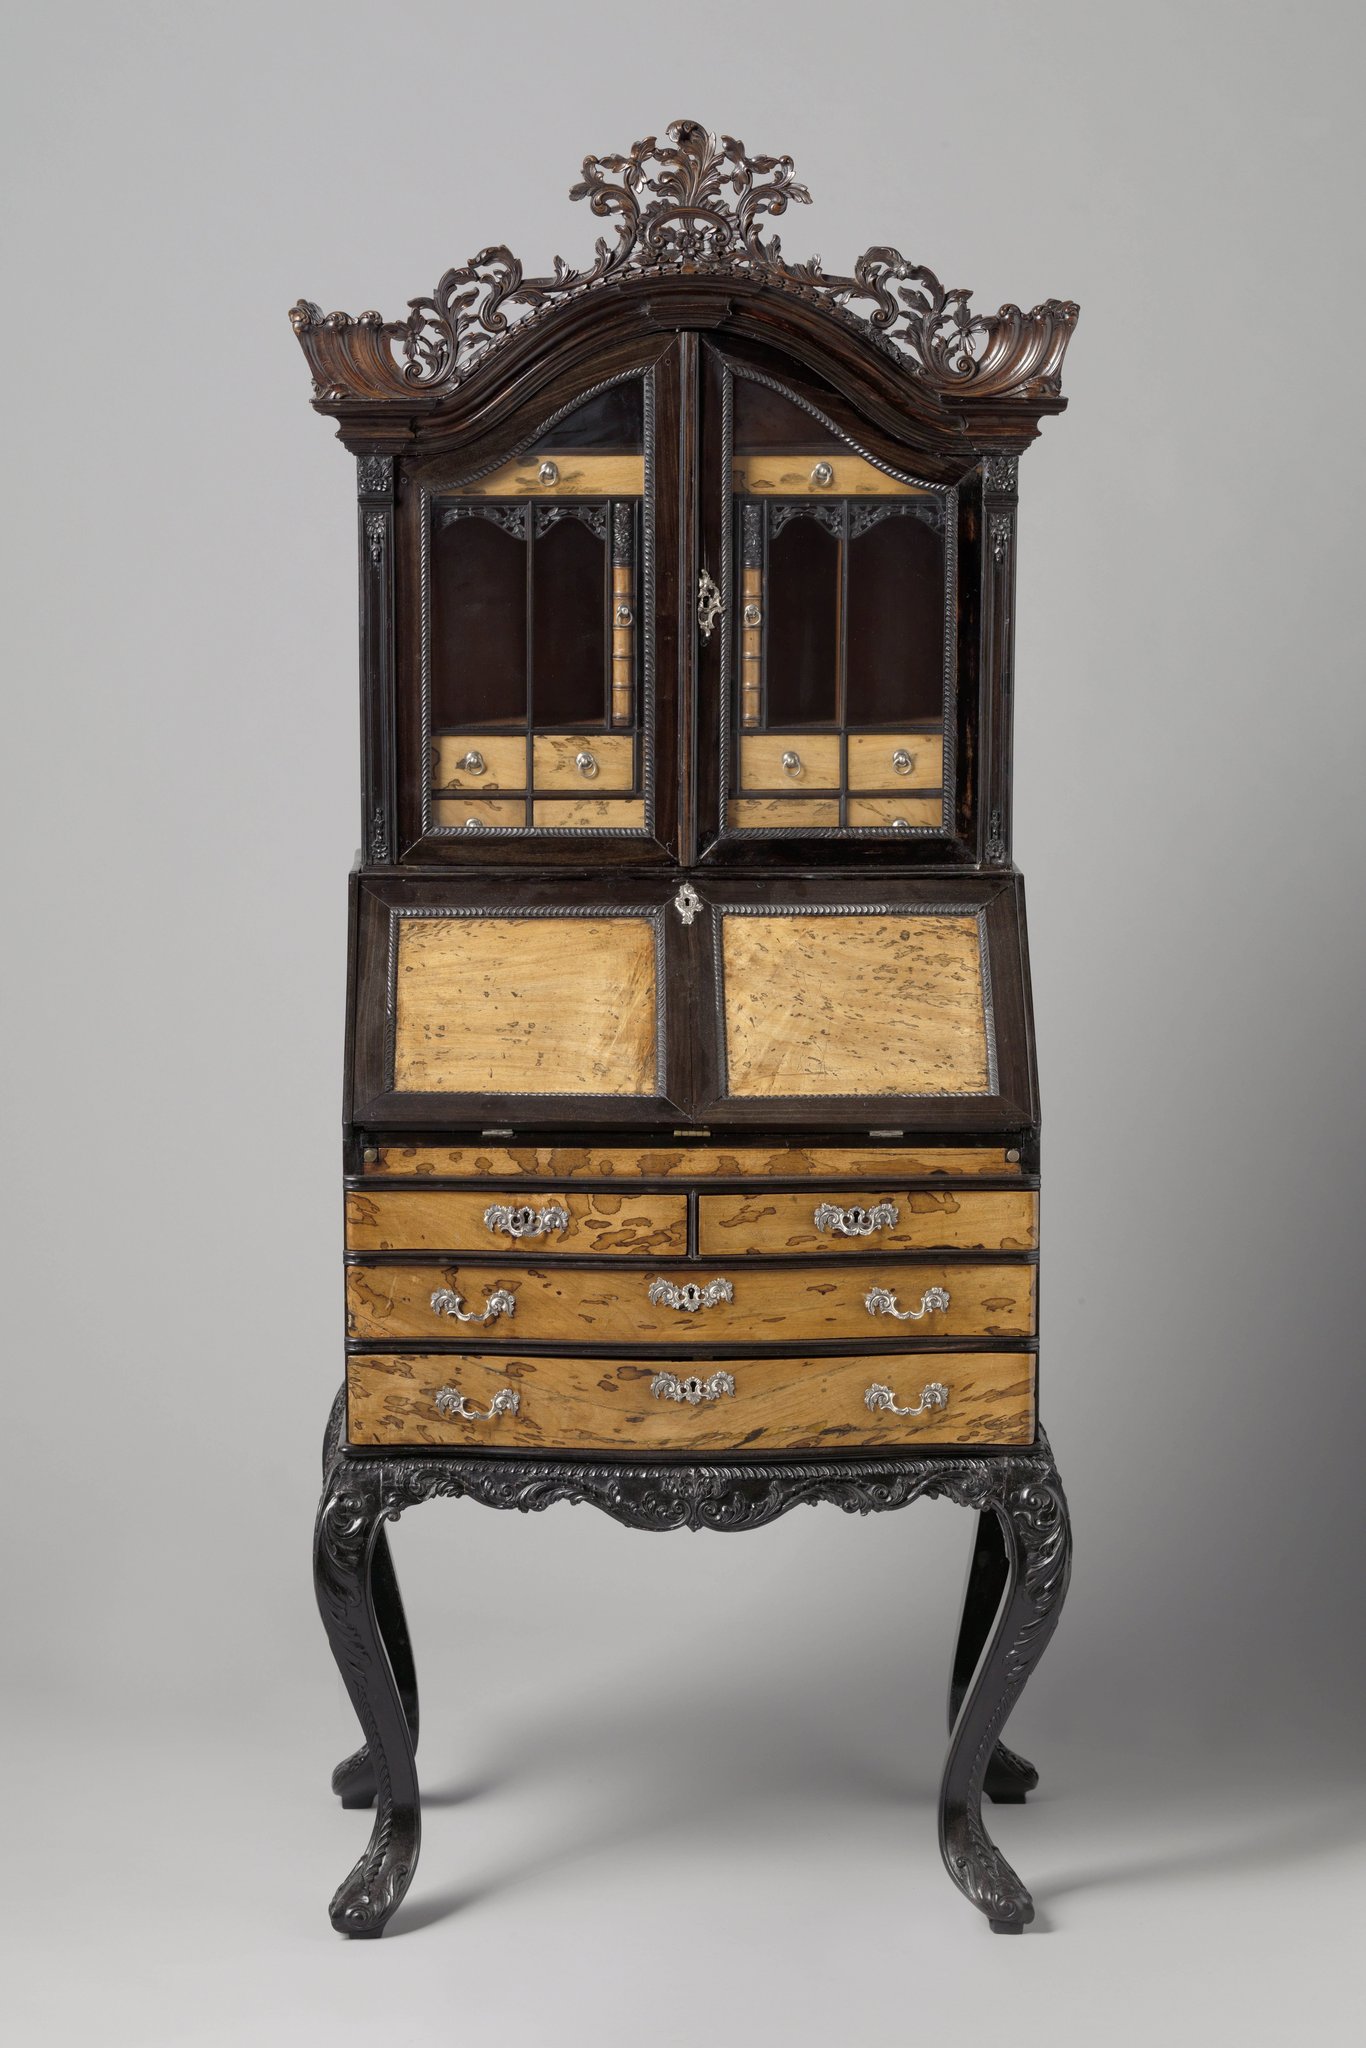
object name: desk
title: Bureau op vier poten, versierd met rocailles, voluten, bloem- en bladwerk, godroenen en profileringen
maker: Anonymous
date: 1785-1800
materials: wood, glass, silver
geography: dutch east indies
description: Schrijfkabinet. Ebben- en ander tropisch hout. Batavia, ca. 1750 - 1775. Aangekocht met gelden uit het legaat M.E.M. de Girard de Mielet van Coehorn.